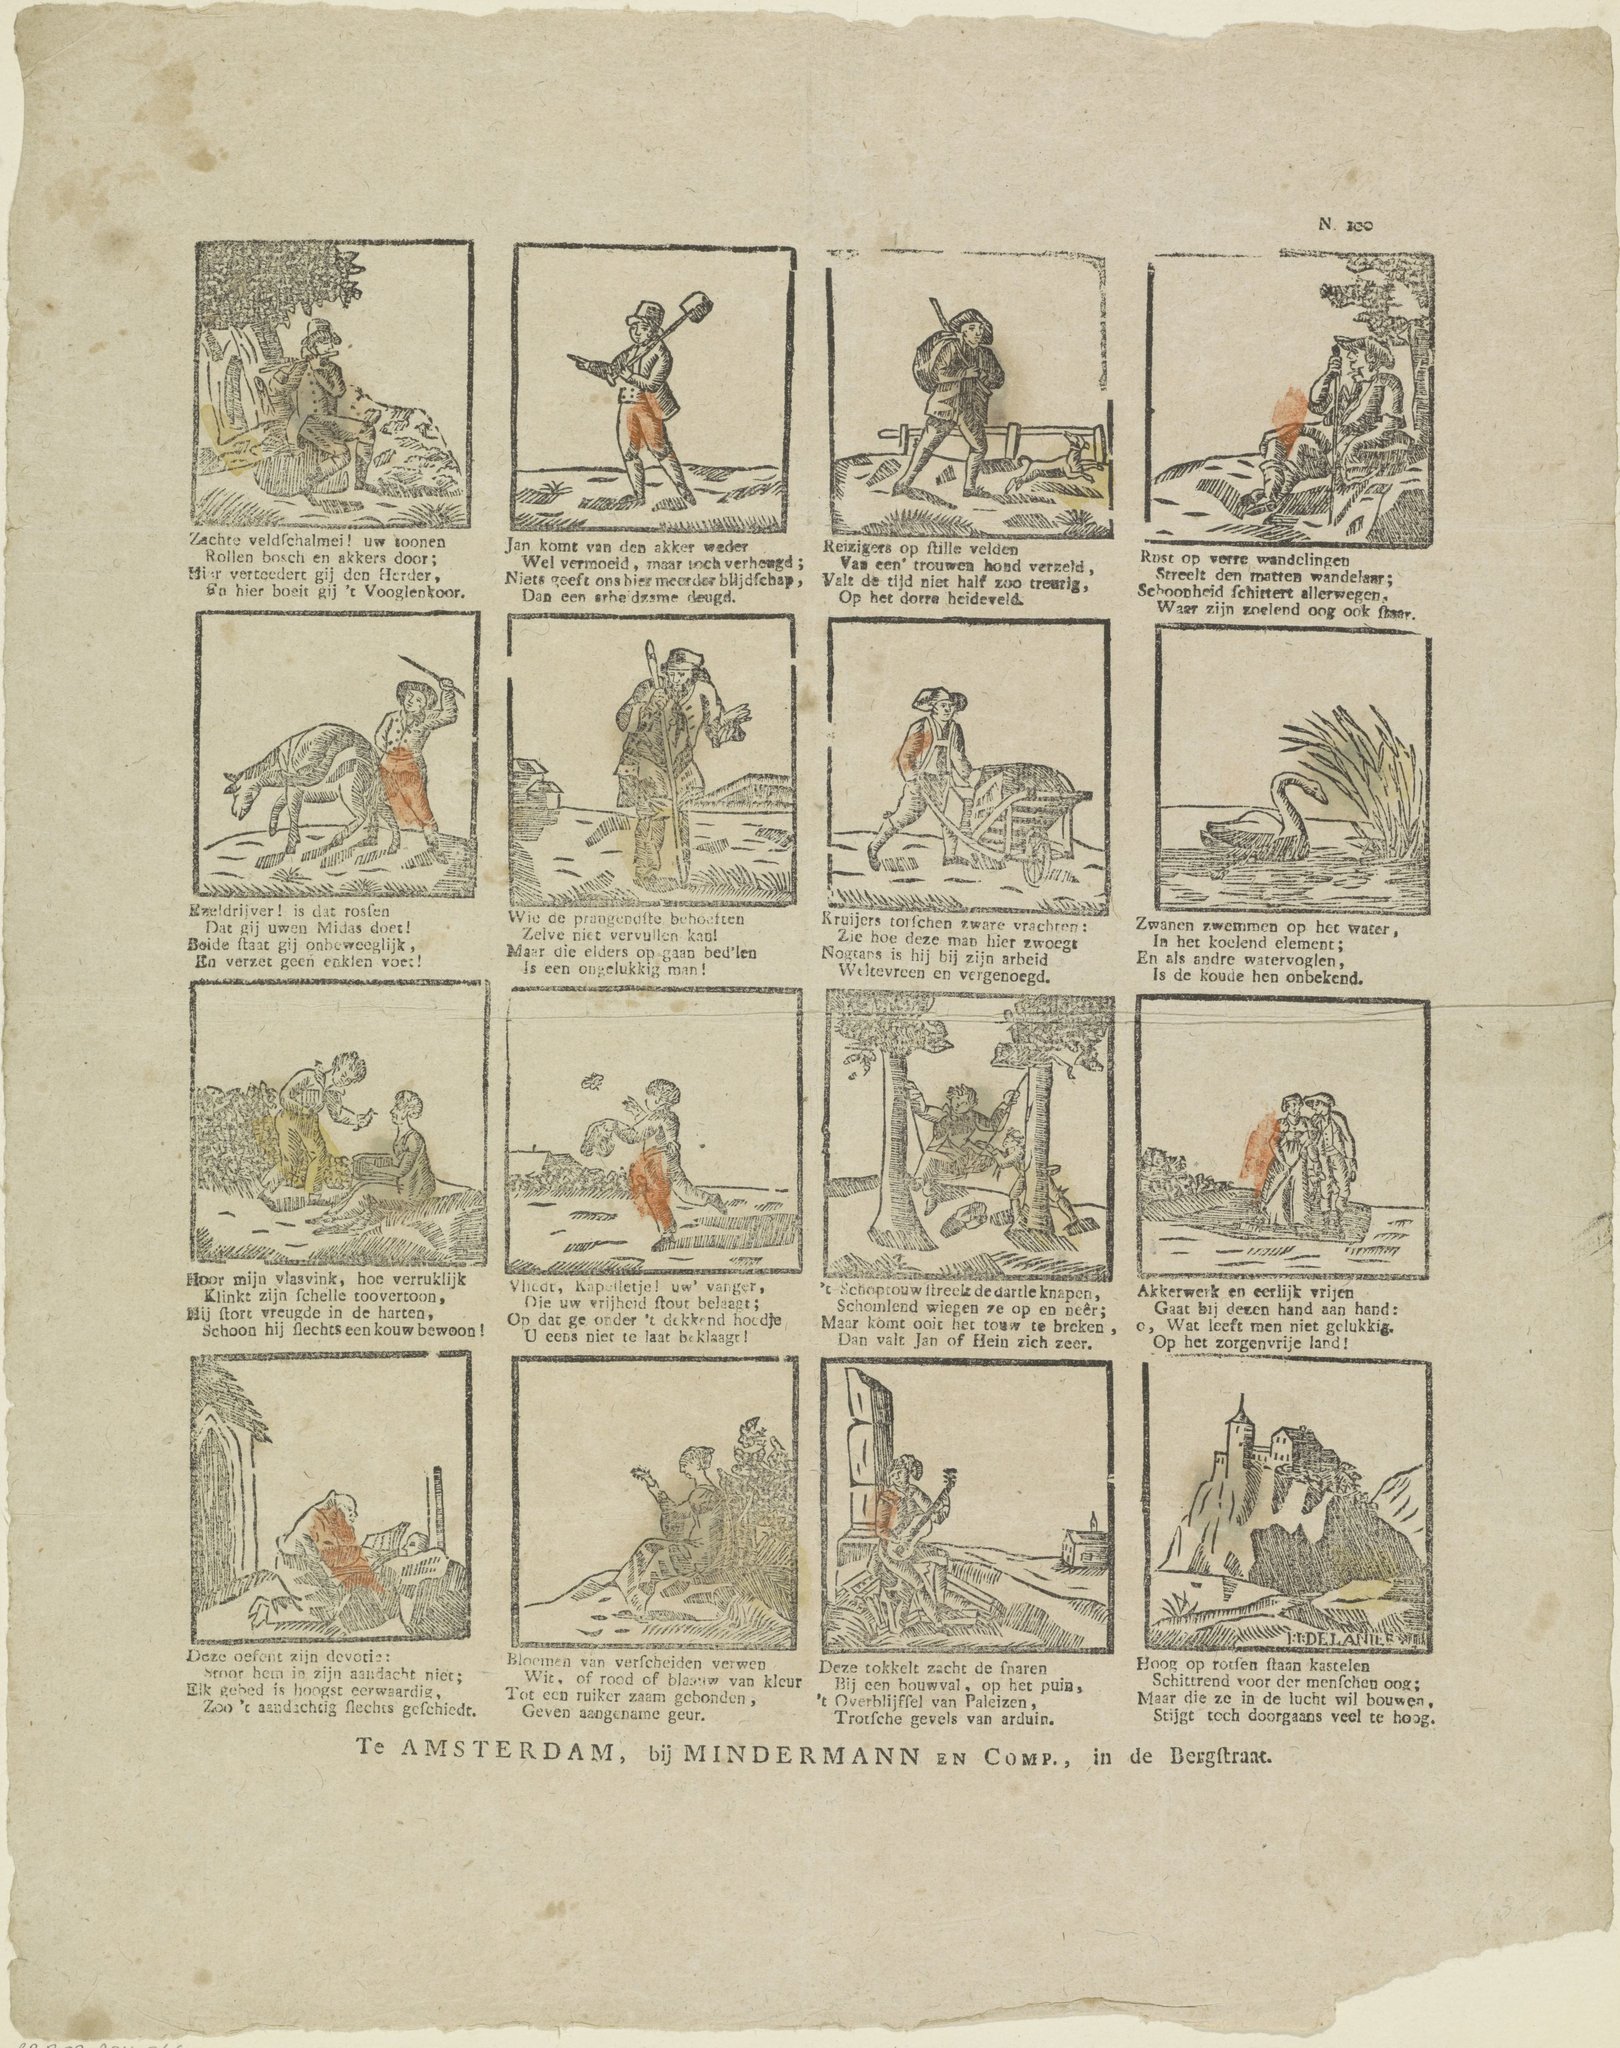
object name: print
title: Spelen en bezigheden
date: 1822-1849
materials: paper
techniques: colour, letterpress printing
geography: deventer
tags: musician at work, children's games and plays, walking, hiking (recreation), swinging (children's game)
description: Blad met 16 voorstellingen van verschillende spelen en bezigheden, zoals fluit spelen, reizen en schommelen. Onder elke afbeelding een vierregelig vers. Genummerd rechtsboven: N. 100.